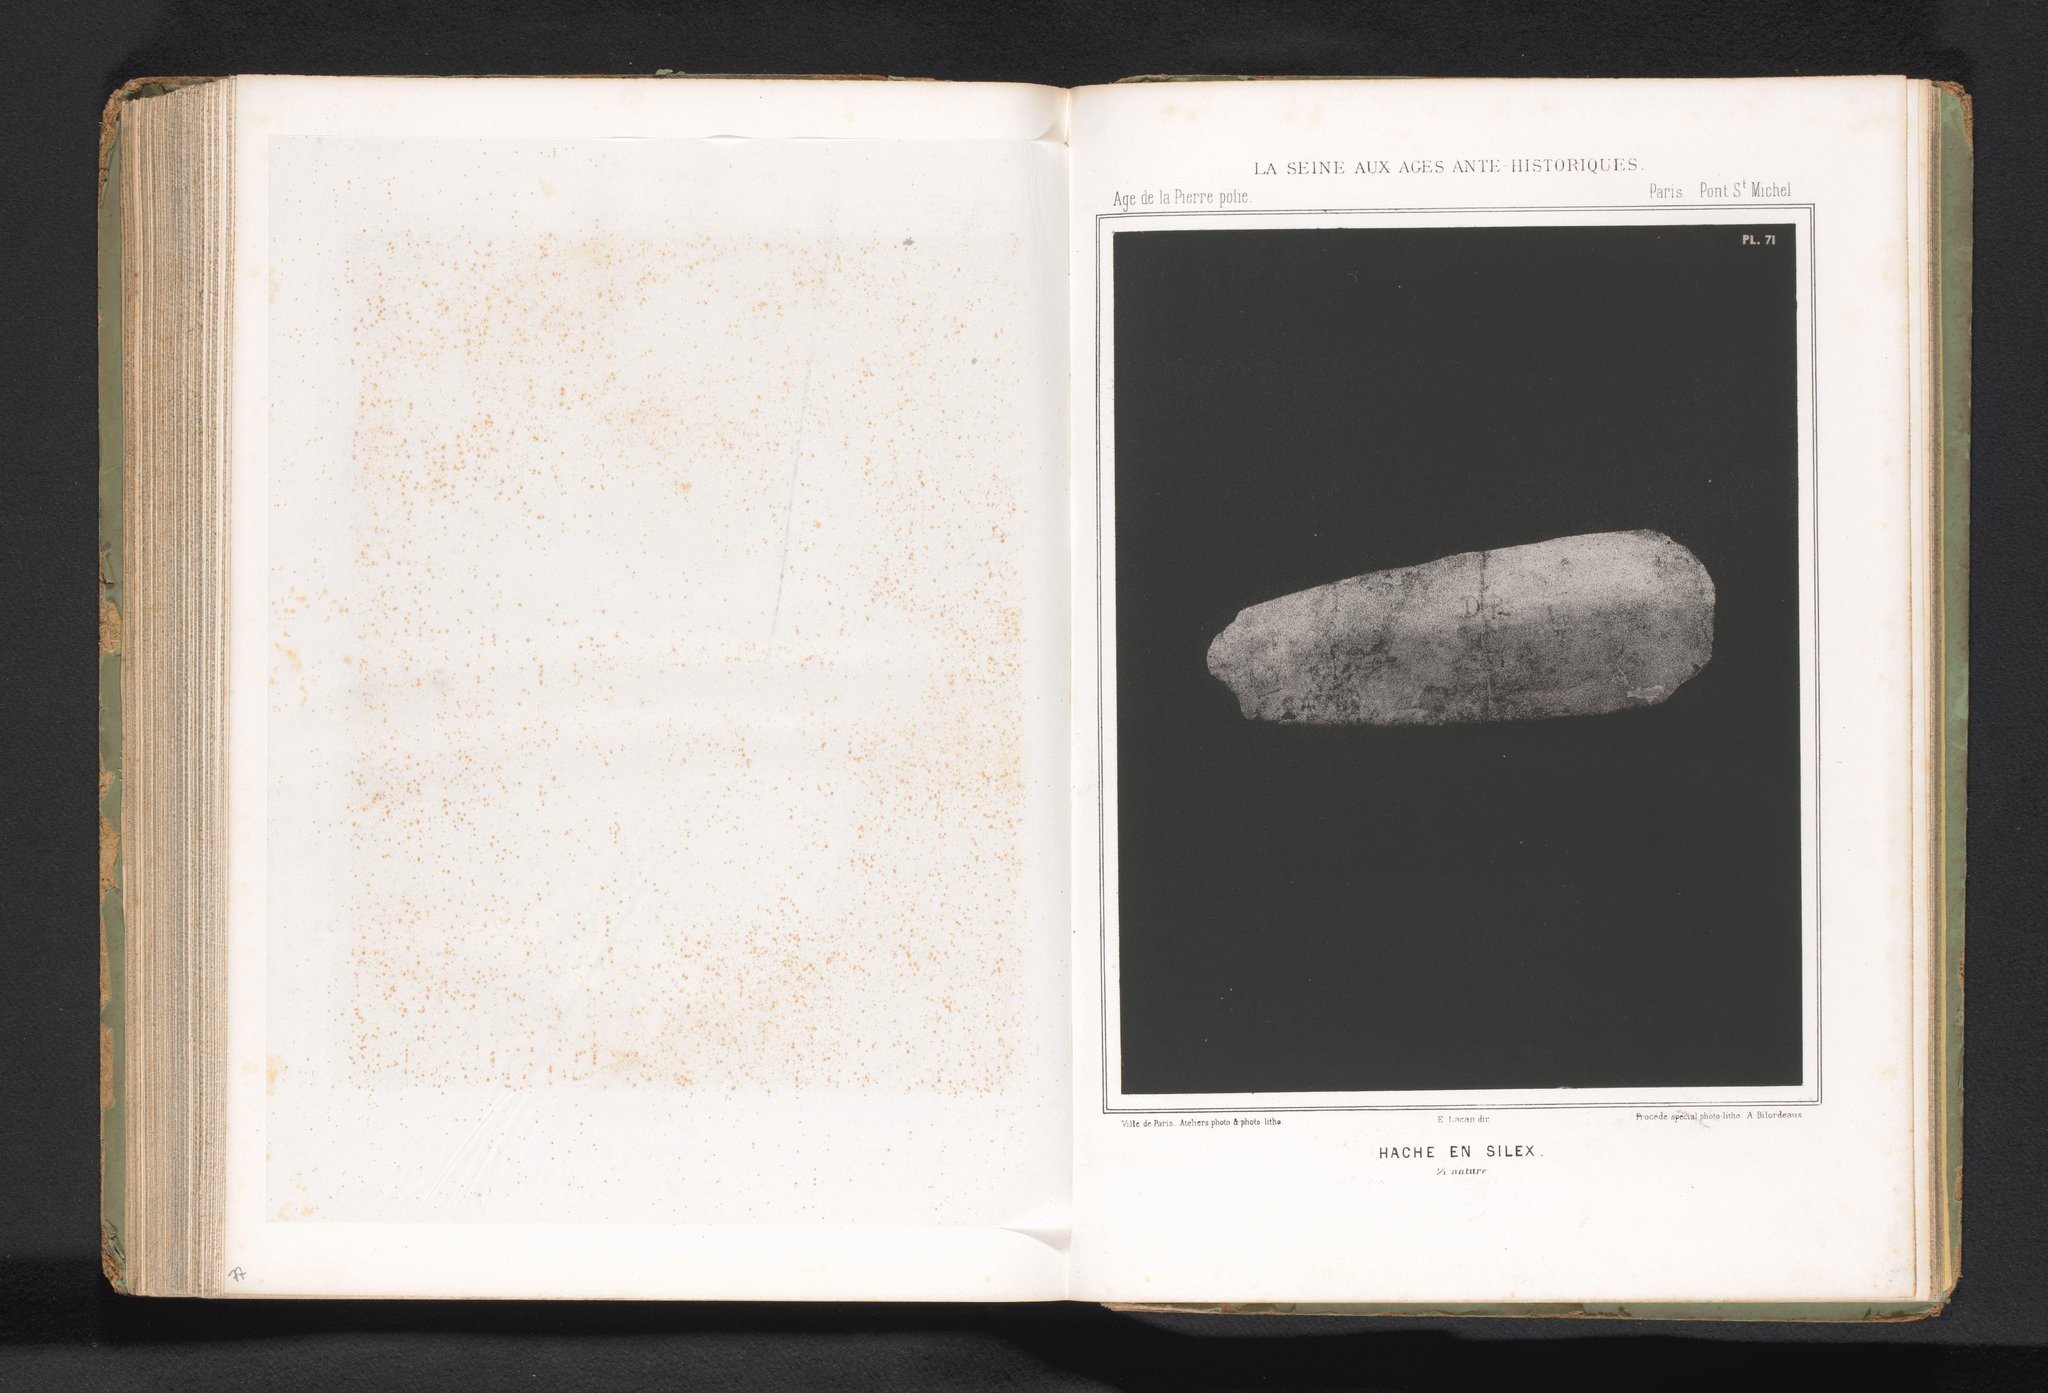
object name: photomechanical print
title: Hache en silex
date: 1864-1869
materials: paper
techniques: photolithography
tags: tools, aids, implements ~ crafts and industries: axe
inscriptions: inscription: ‘Procédé spécial photo-litho. A. Bilordeaux’, inscription: ‘PL.71’, inscription: ‘1/1 nature’